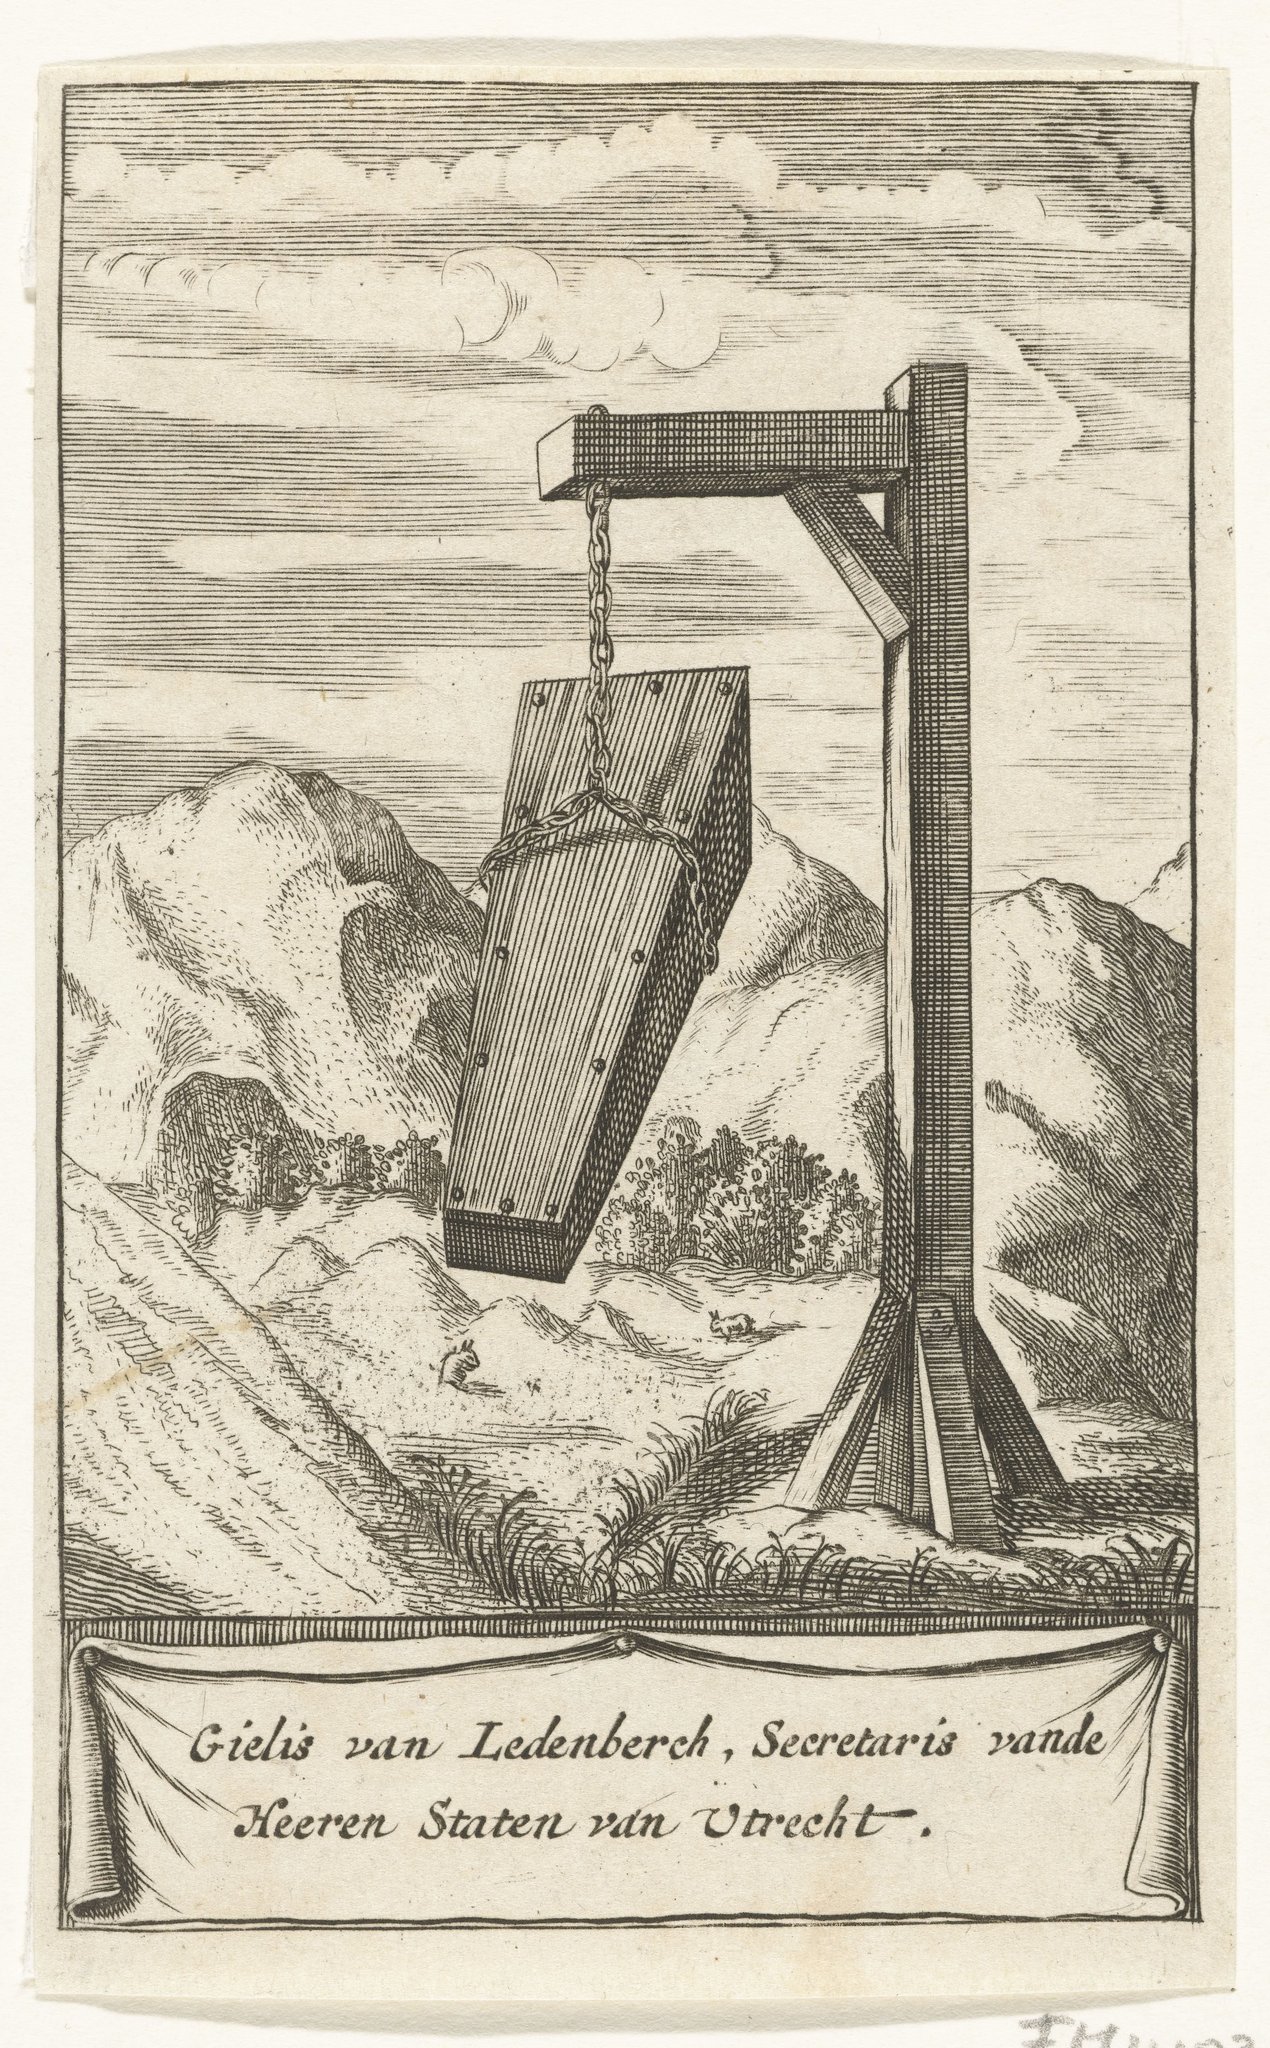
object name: print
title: De doodskist van Ledenberg aan de galg, 1619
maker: Anonymous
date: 1619-1699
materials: paper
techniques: engraving, etching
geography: northern netherlands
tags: utrecht, the hague, violent death by hanging, seeking death, suicide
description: De kist met de overblijfselen van Gilles van Ledenberg hangend aan de galg in de duinen buiten Den Haag, 15 mei 1619.